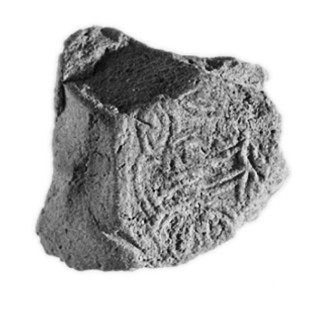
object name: sealing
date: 1981-1640 BCE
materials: mud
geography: egypt